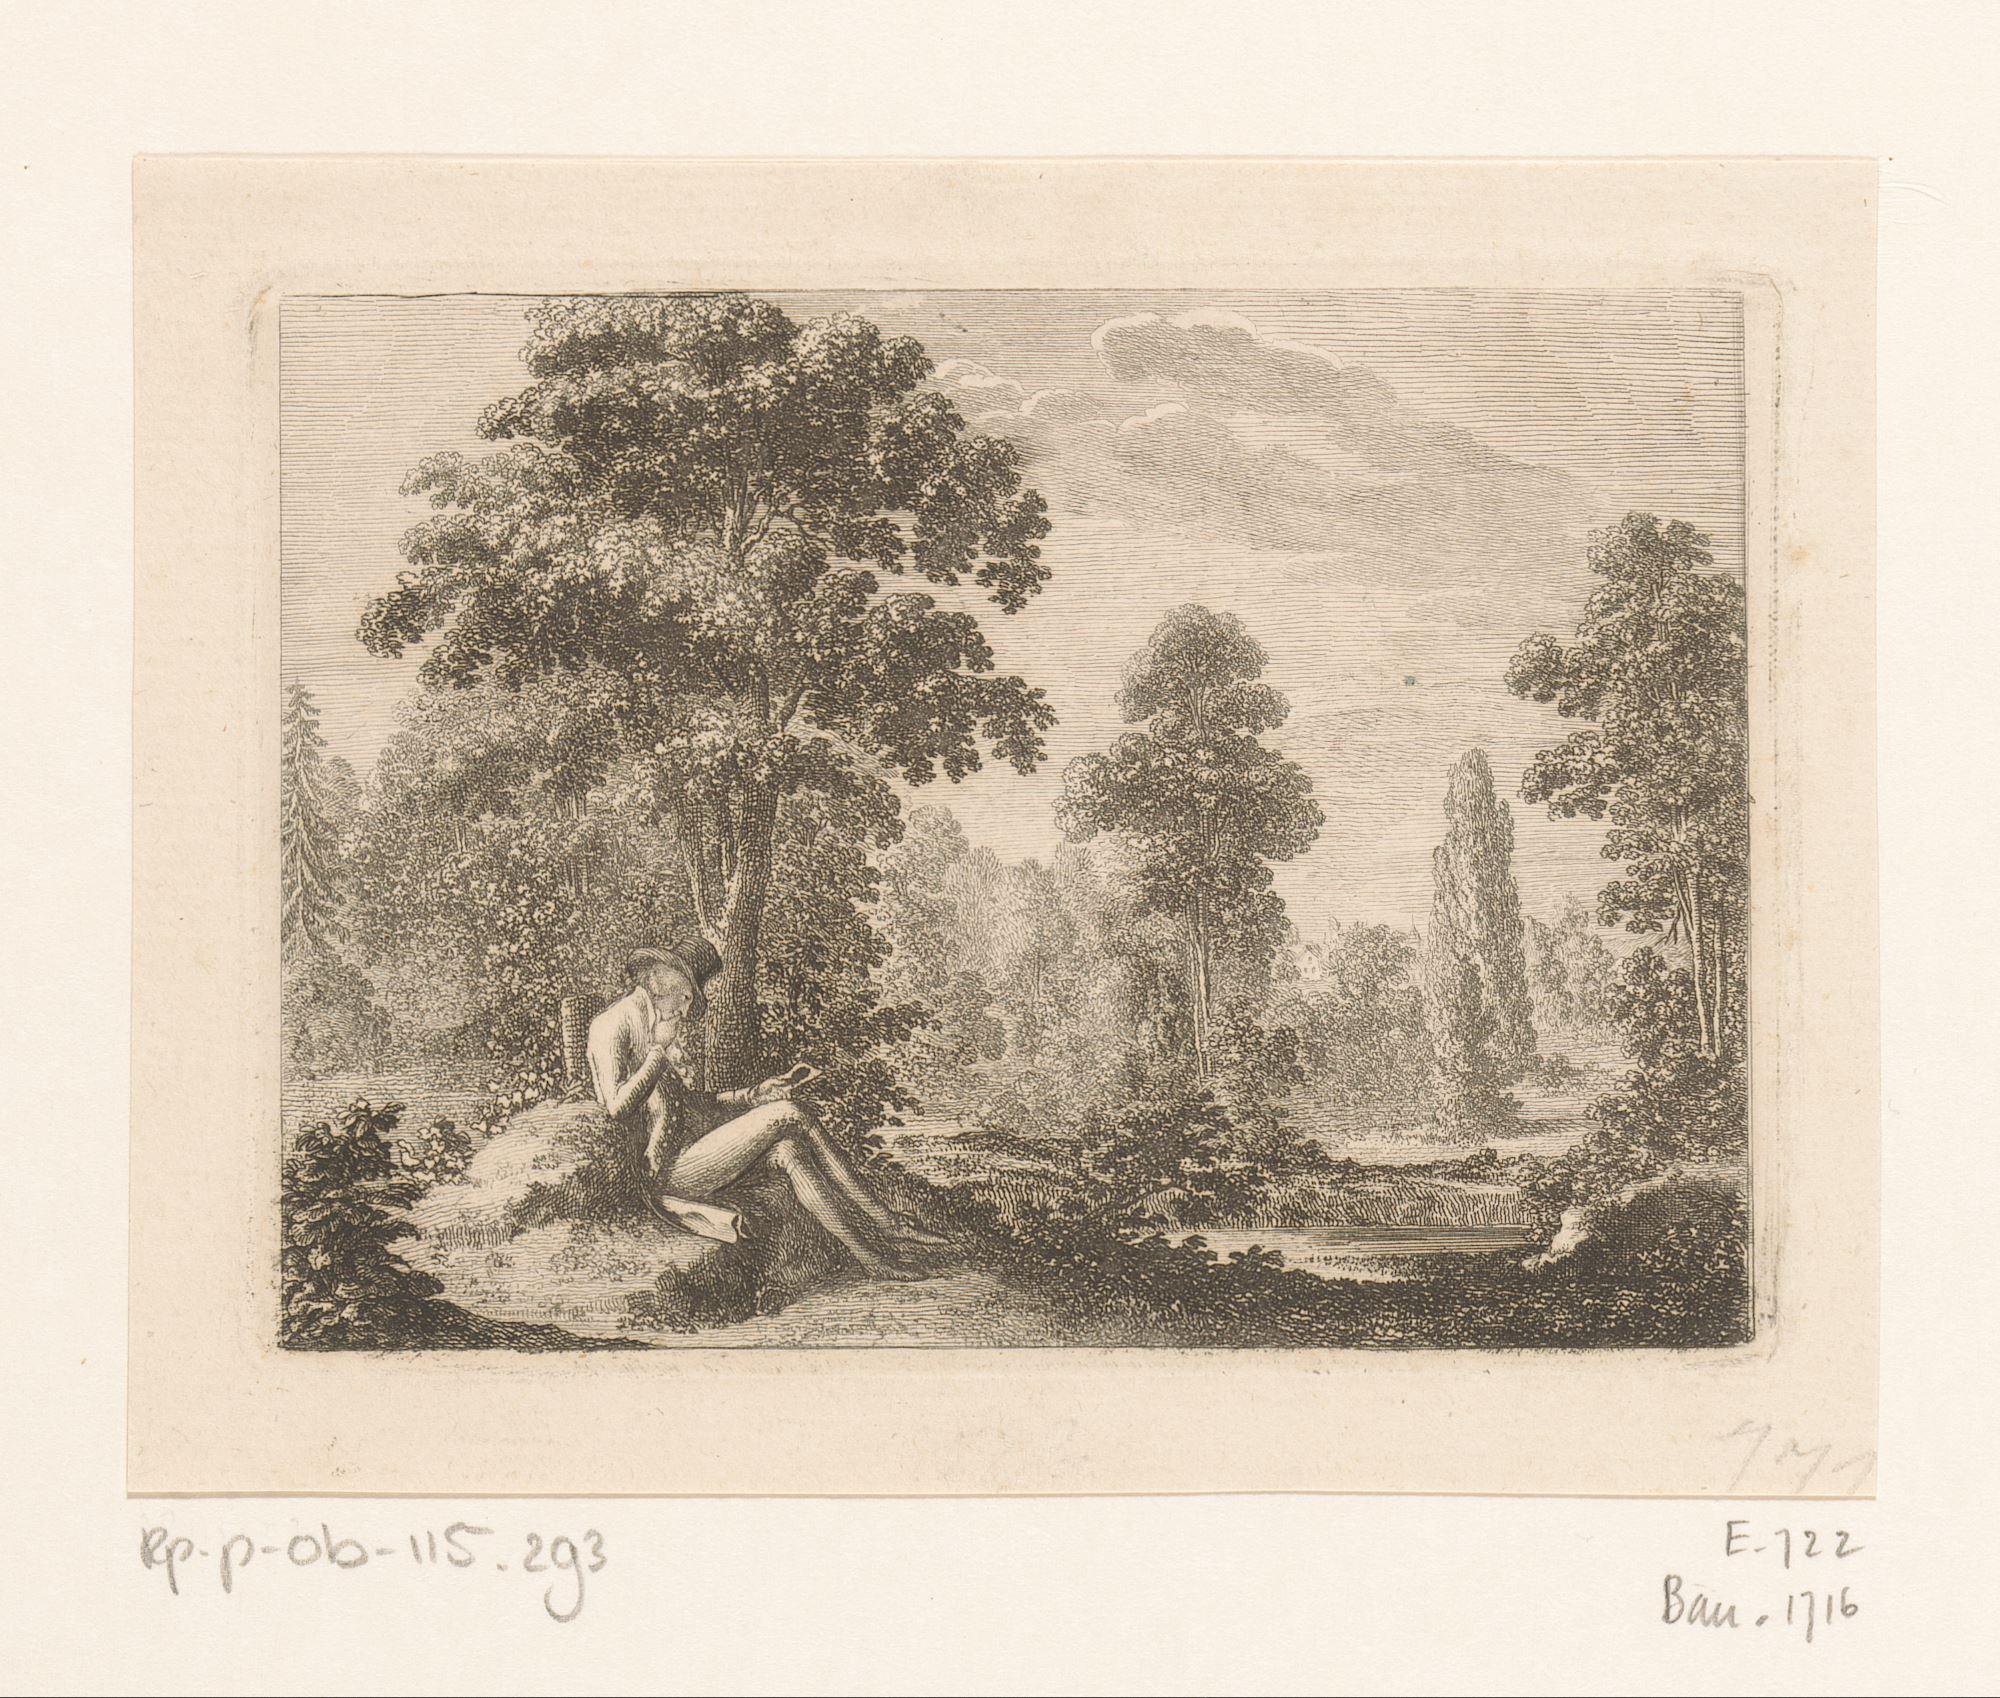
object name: print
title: Landschap met een jongeman die naar het silhouet van een vrouw kijkt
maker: daniel nikolaus chodowiecki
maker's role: draughtsman, print maker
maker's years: 1726-1801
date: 1793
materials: paper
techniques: etching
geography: berlin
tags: landscapes, youth, adolescent, lover with love-letter, anonymous historical person portrayed - bb - woman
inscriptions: collector's mark: Lugt 2228